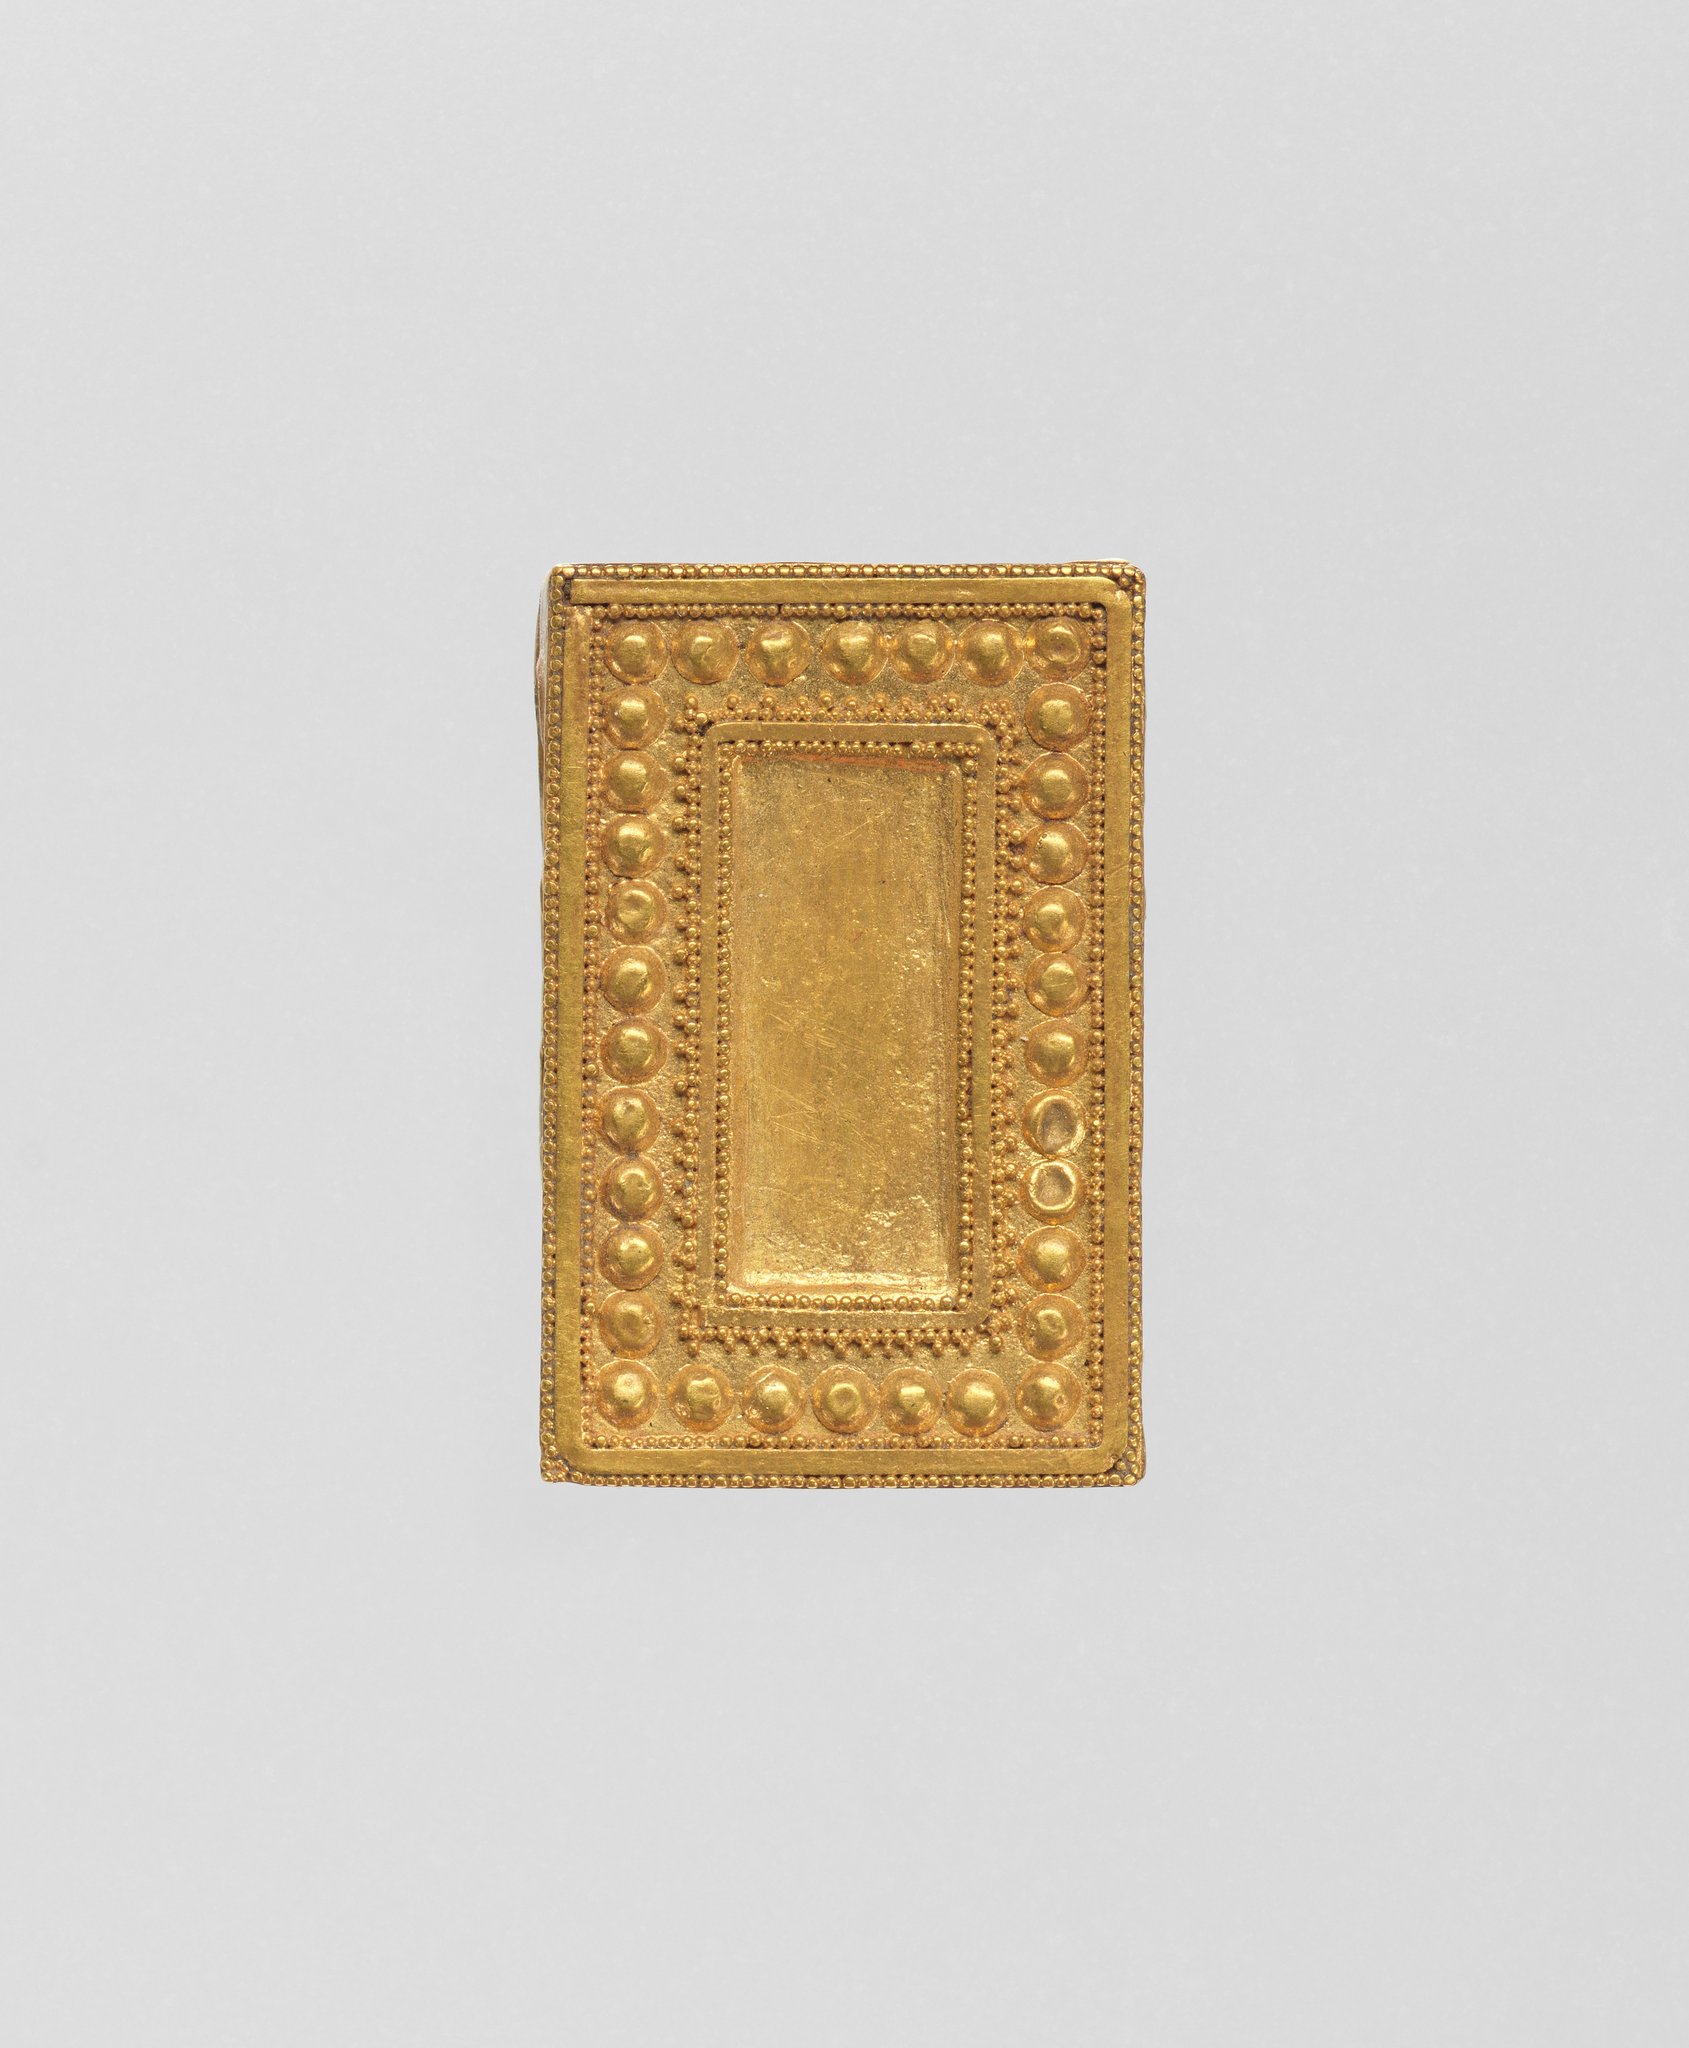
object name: broad collar spacer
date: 332-330 BCE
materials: gold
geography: egypt